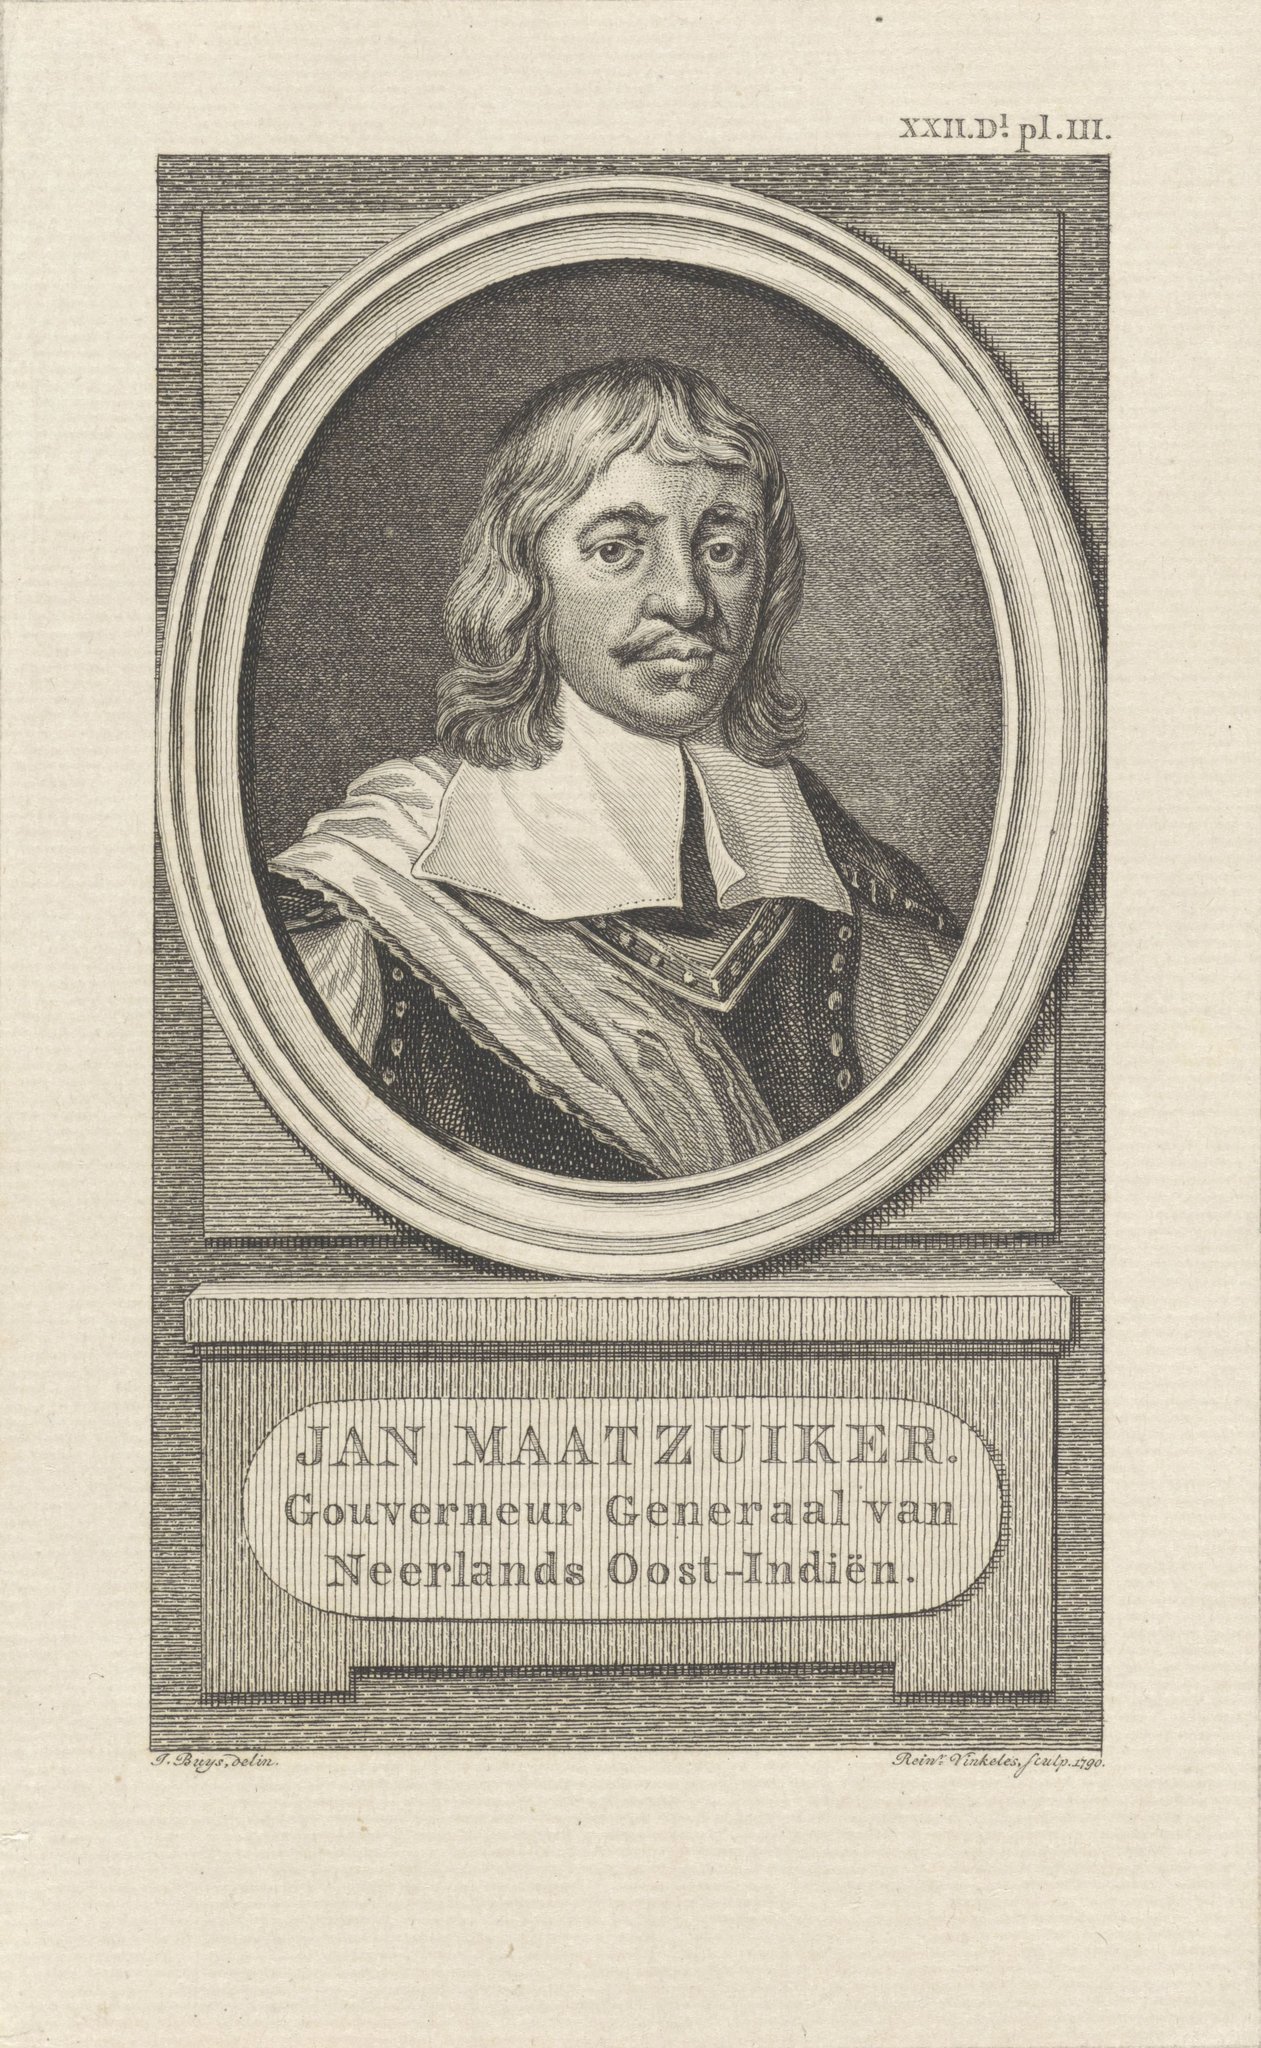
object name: print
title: Portret van Joan Maetsuyker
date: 1790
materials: paper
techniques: etching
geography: amsterdam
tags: amsterdam, batavia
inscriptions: collector's mark: Lugt 2228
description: Prent gebruikt als boekillustratie in: Kok, Jacobus. Vaderlandsch woordenboek : met kaarten, plaaten en pourtraitten. Amsterdam: Johannes Allart, 1785-1796. Deel XXII.